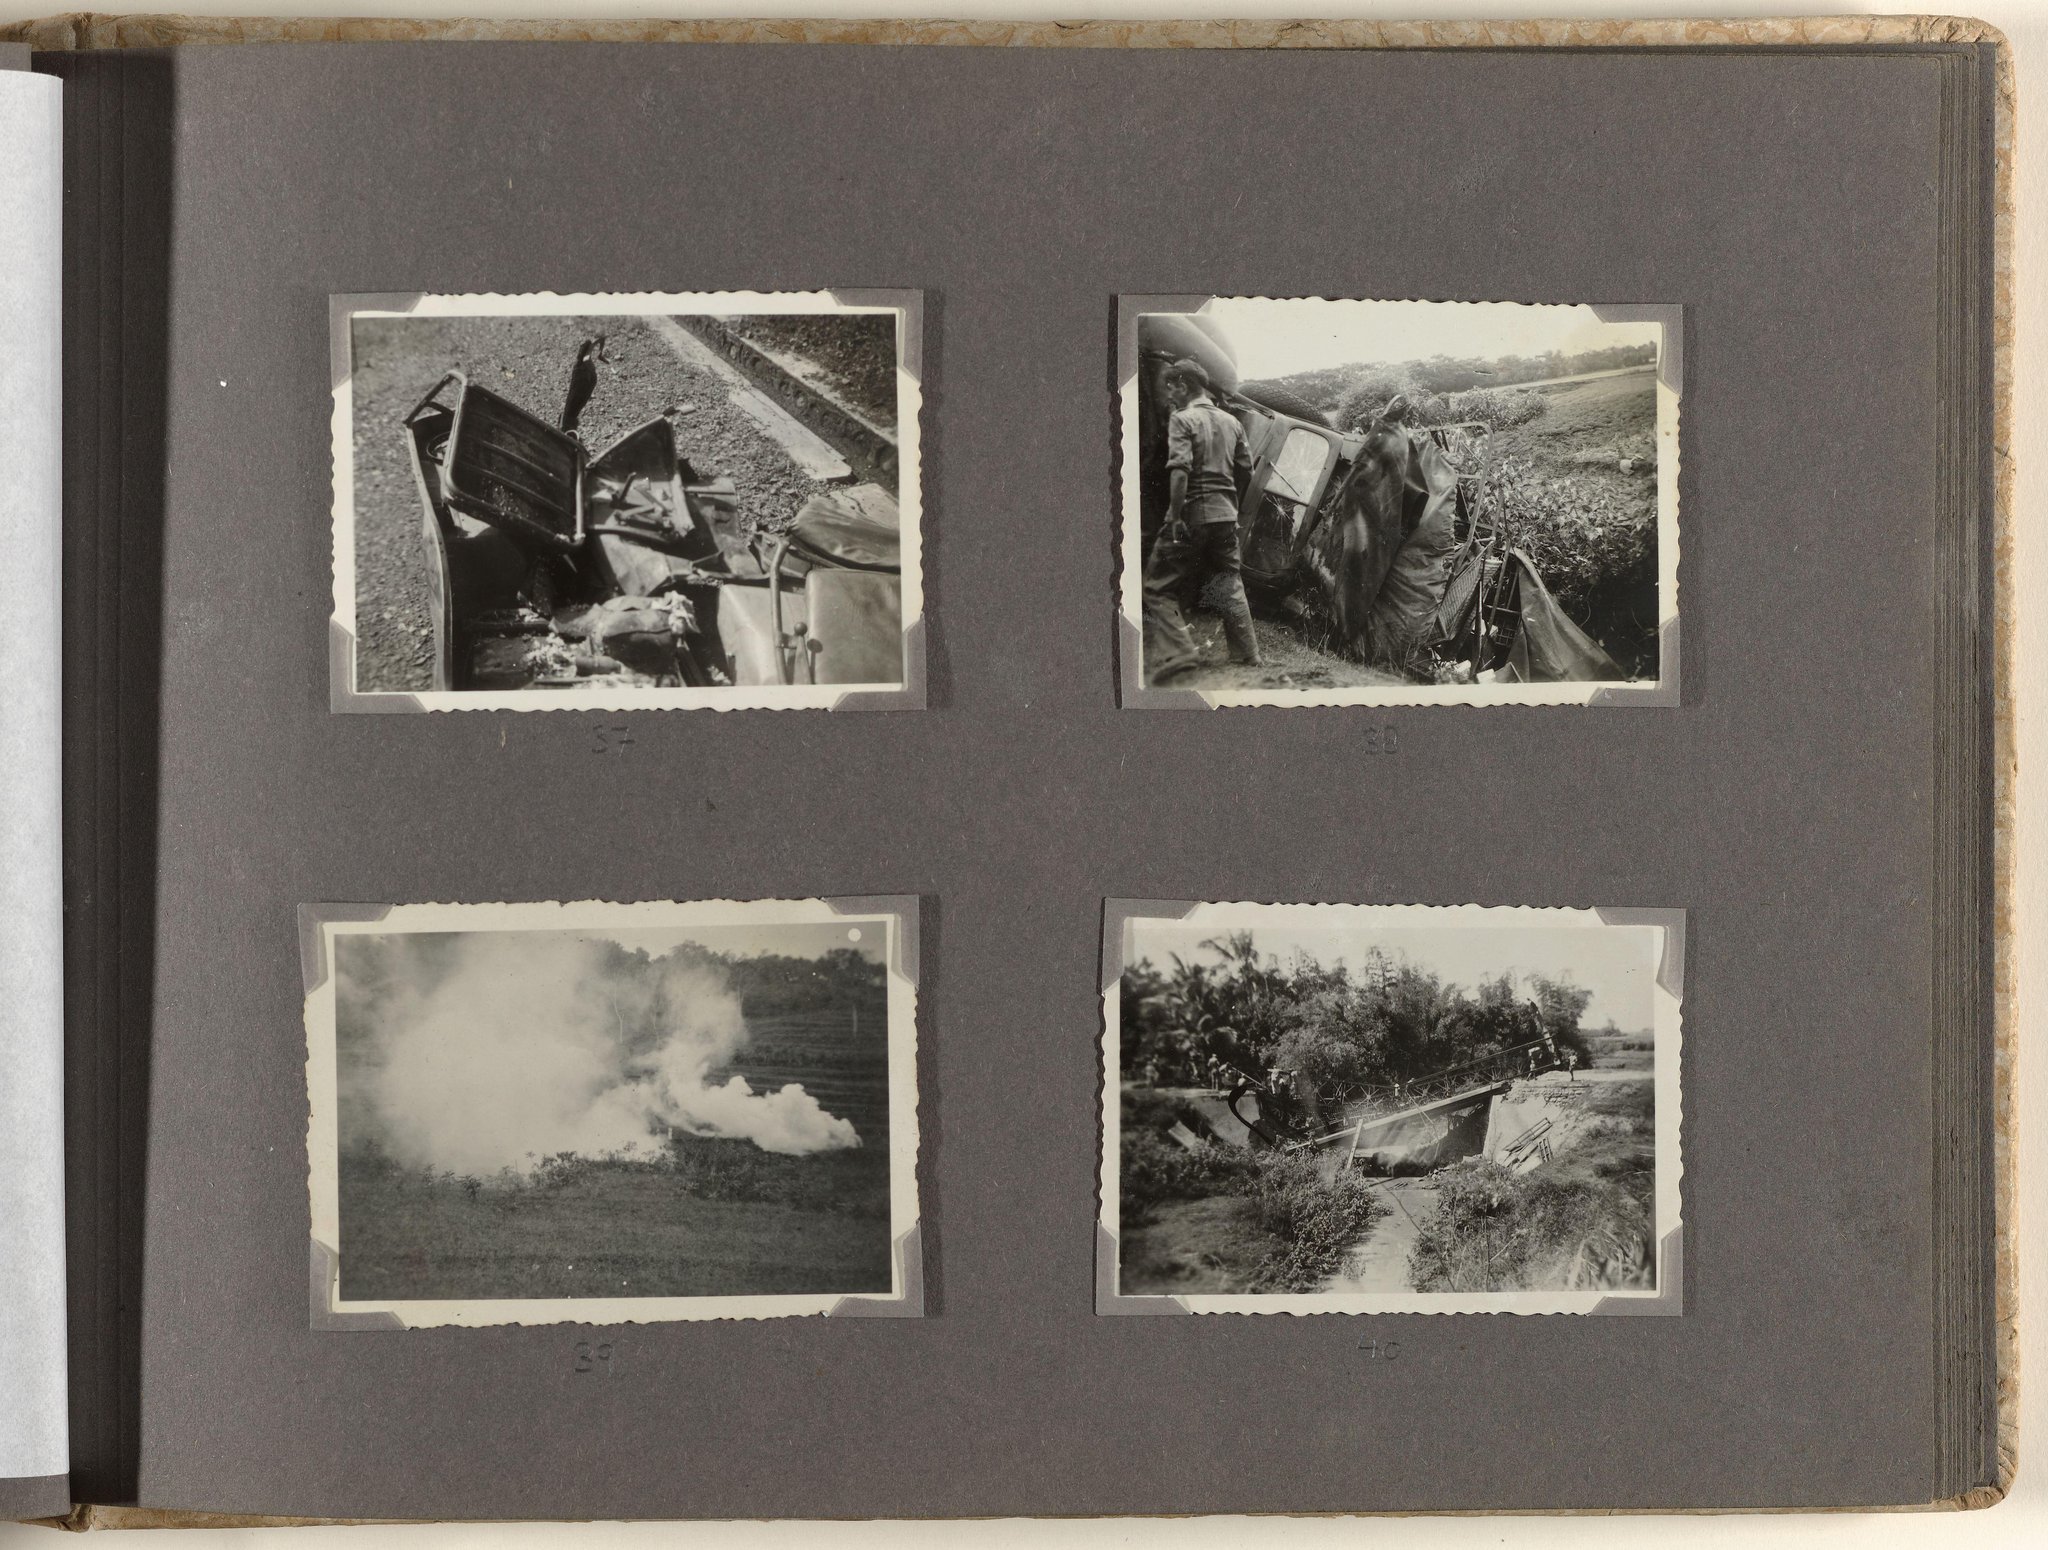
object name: photograph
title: Verongelukte vrachtauto en gesaboteerde brug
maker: Anonymous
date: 1946-1949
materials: cardboard, photographic support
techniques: gelatin silver print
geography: dutch east indies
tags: dutch east indies, the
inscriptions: inscription: ‘Tasik Madoe.’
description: Albumblad met vier foto's: verongelukte vrachtauto bij Tasik Madoe, rookwolken over een veld en een gesaboteerde brug. Onderdeel van het fotoalbum over de diensttijd van Nederlandse militairen in Indië, ca. 1946-1949.